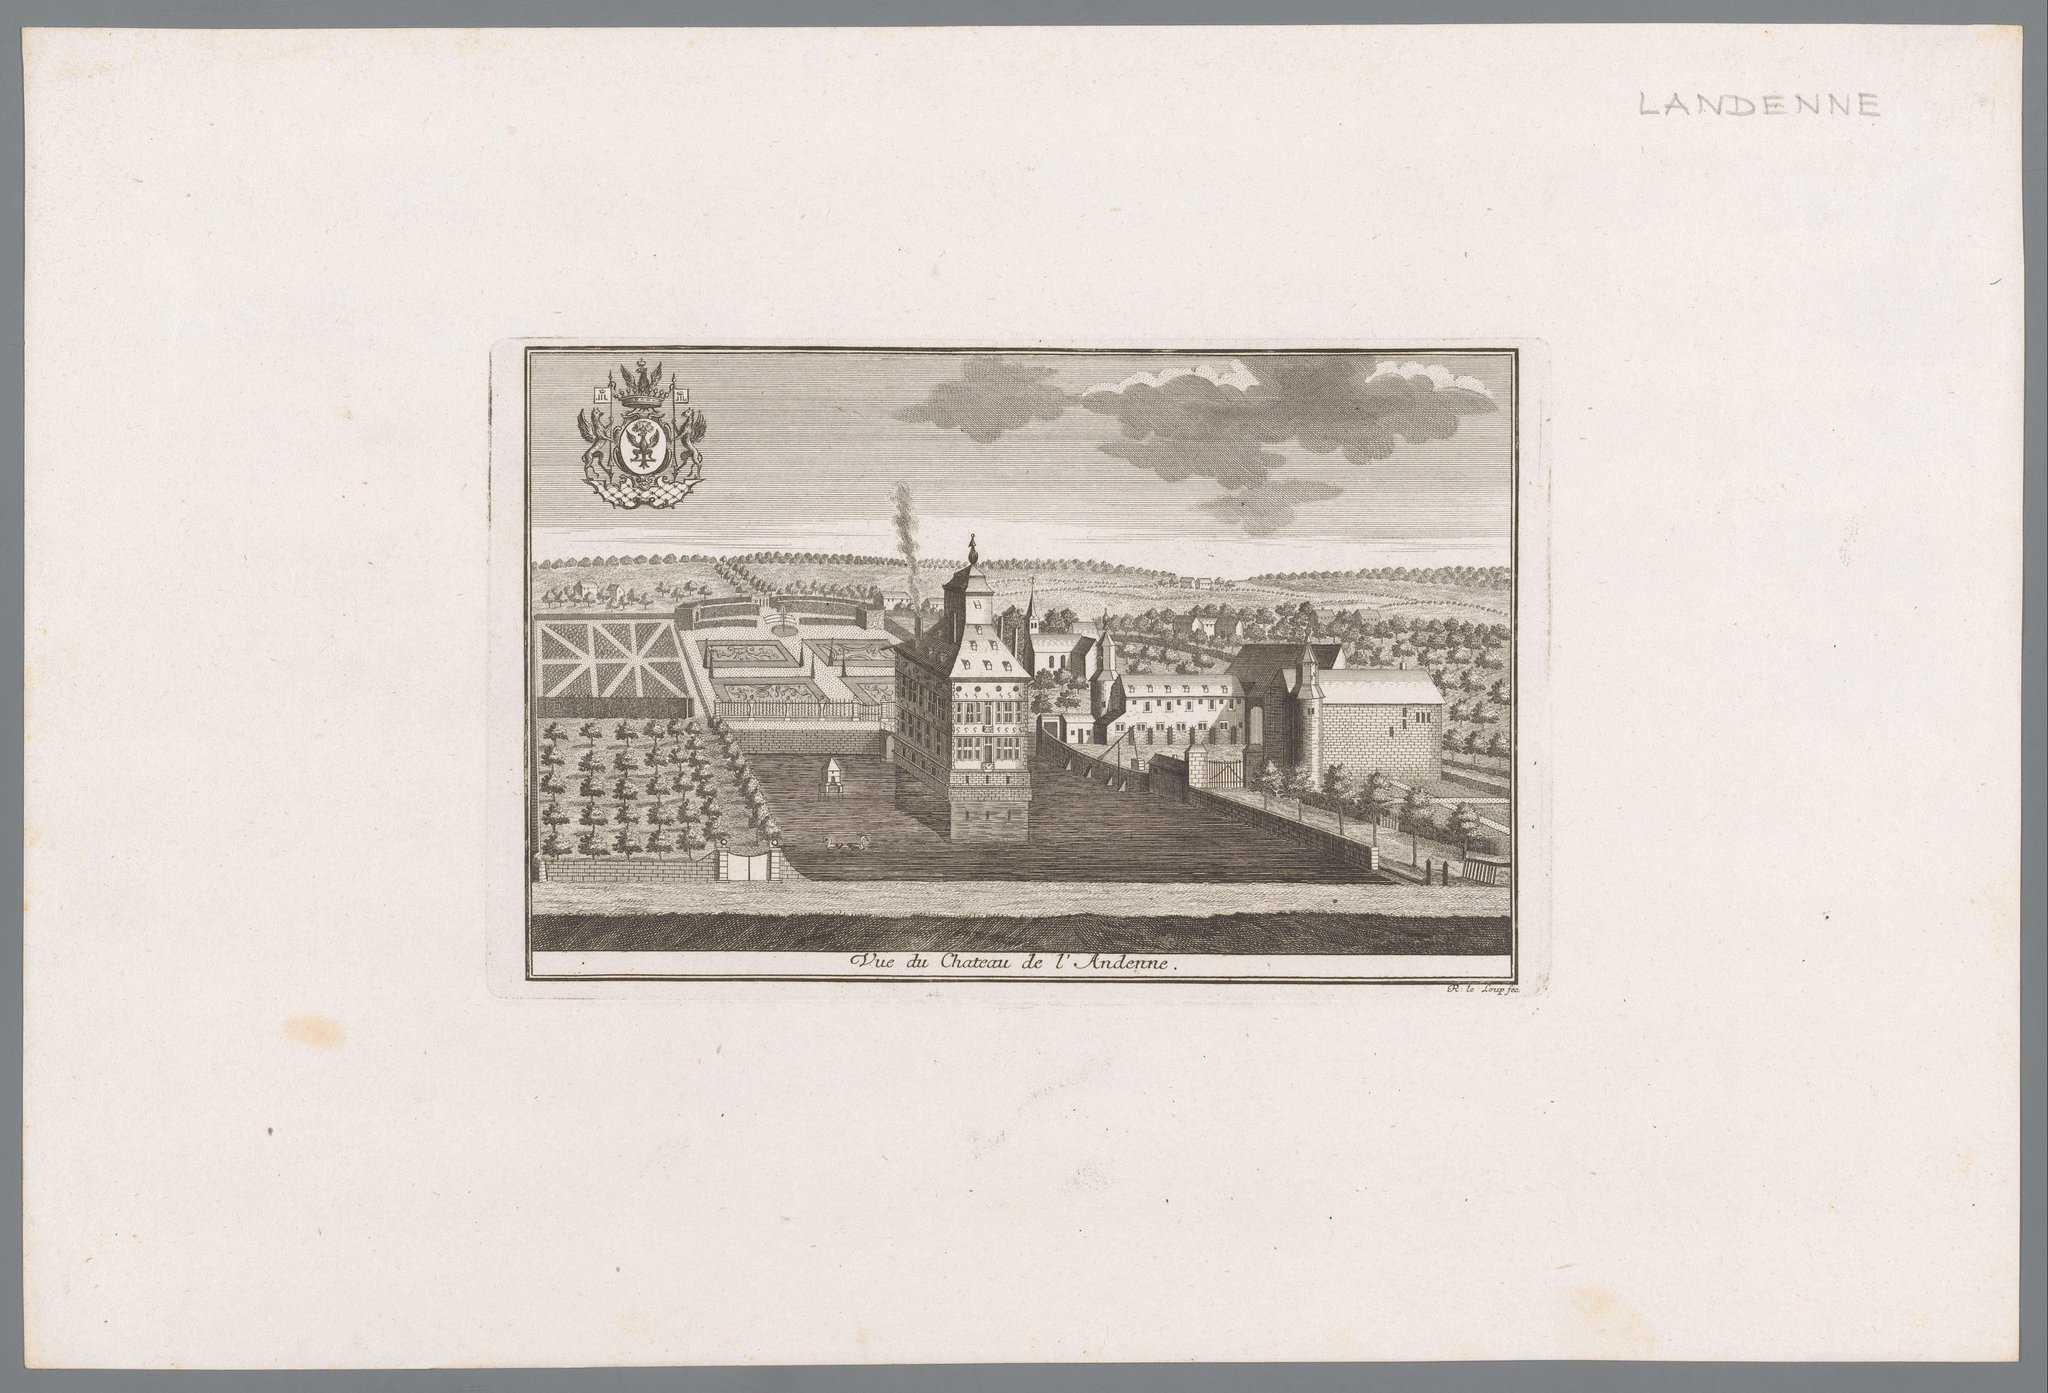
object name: book illustration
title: Vue du chateau de l'Andenne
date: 1738-1744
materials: paper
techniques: engraving, etching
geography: liège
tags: abbey, monastery, convent ~ roman catholic church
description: Prent uit: Johanne de Saumery, Alexandre de et al. Les délices du païs de Liège, ou description géographique, topographique et chorographique des monumes sacrés et profanes (...). 5 dln. Luik: Everard Kints, 1738-1744, dl. 2, p. 93.